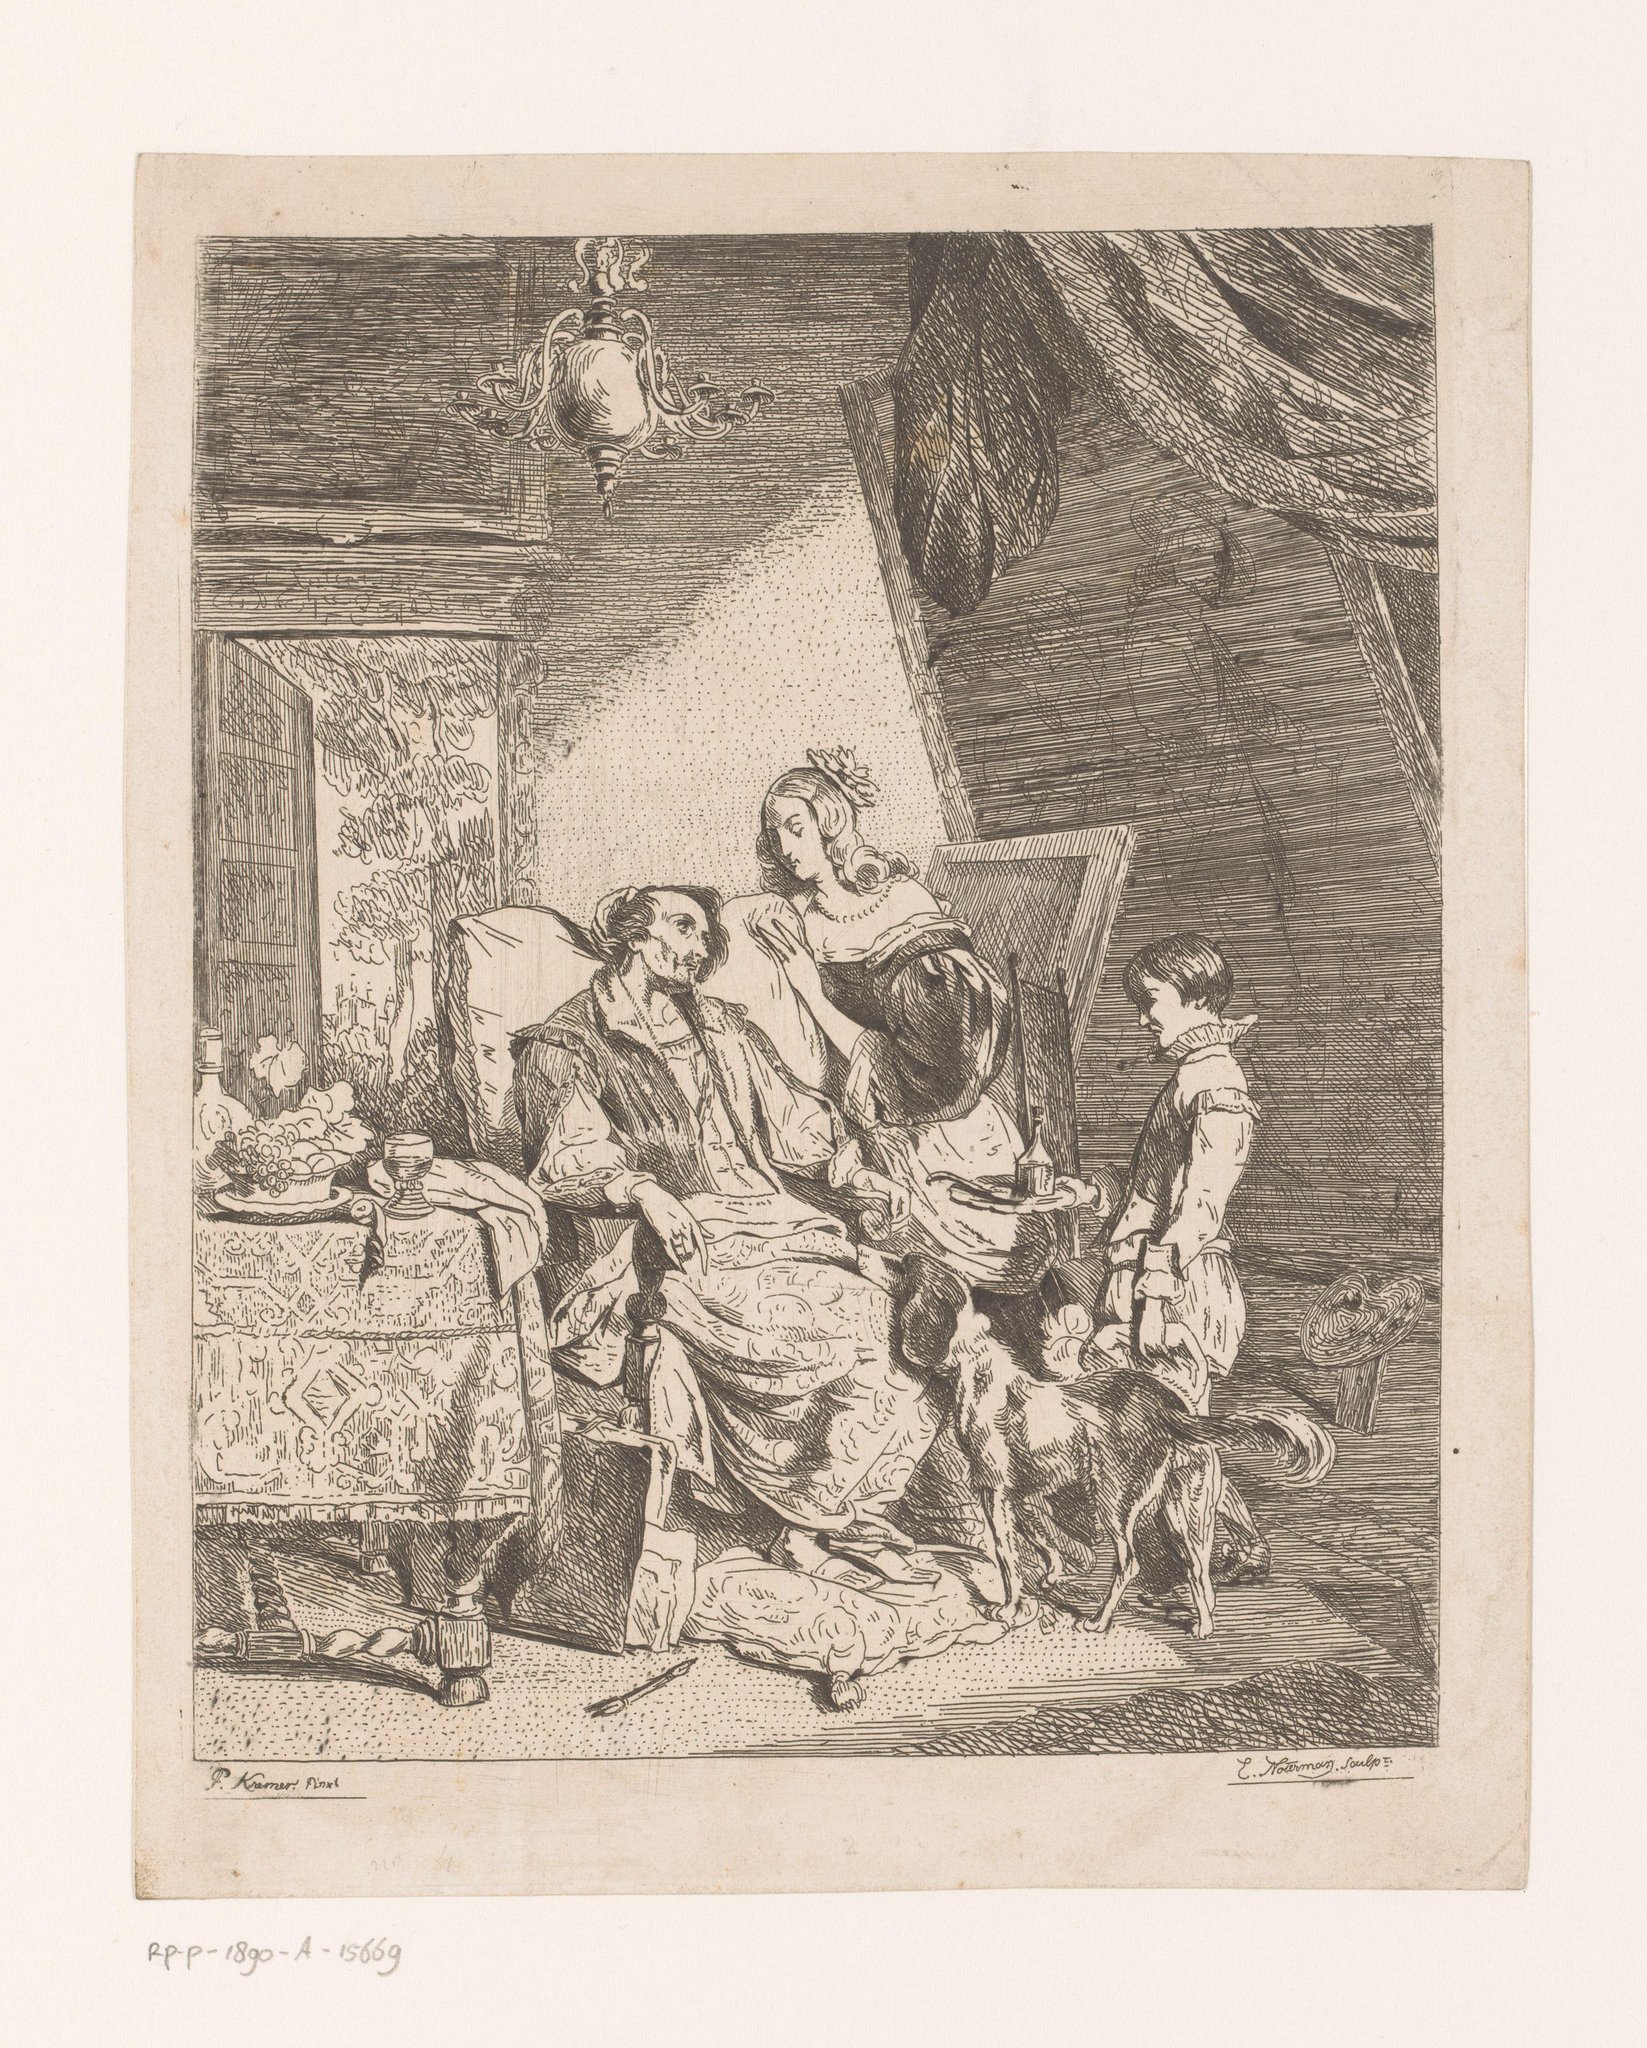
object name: print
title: Anthony van Dyck op zijn sterfbed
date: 1818-1863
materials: paper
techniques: etching, intaglio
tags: antwerp, london, painter, print maker, draughtsman, anthony van dyck, deathbed, interior ~ representation of a building, medicament, medicine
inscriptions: collector's mark: Lugt 2228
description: Van Dyck zit in een grote stoel bij een tafel met om zich heen een vrouw, jongen met een blad met medicijnen en een hond.